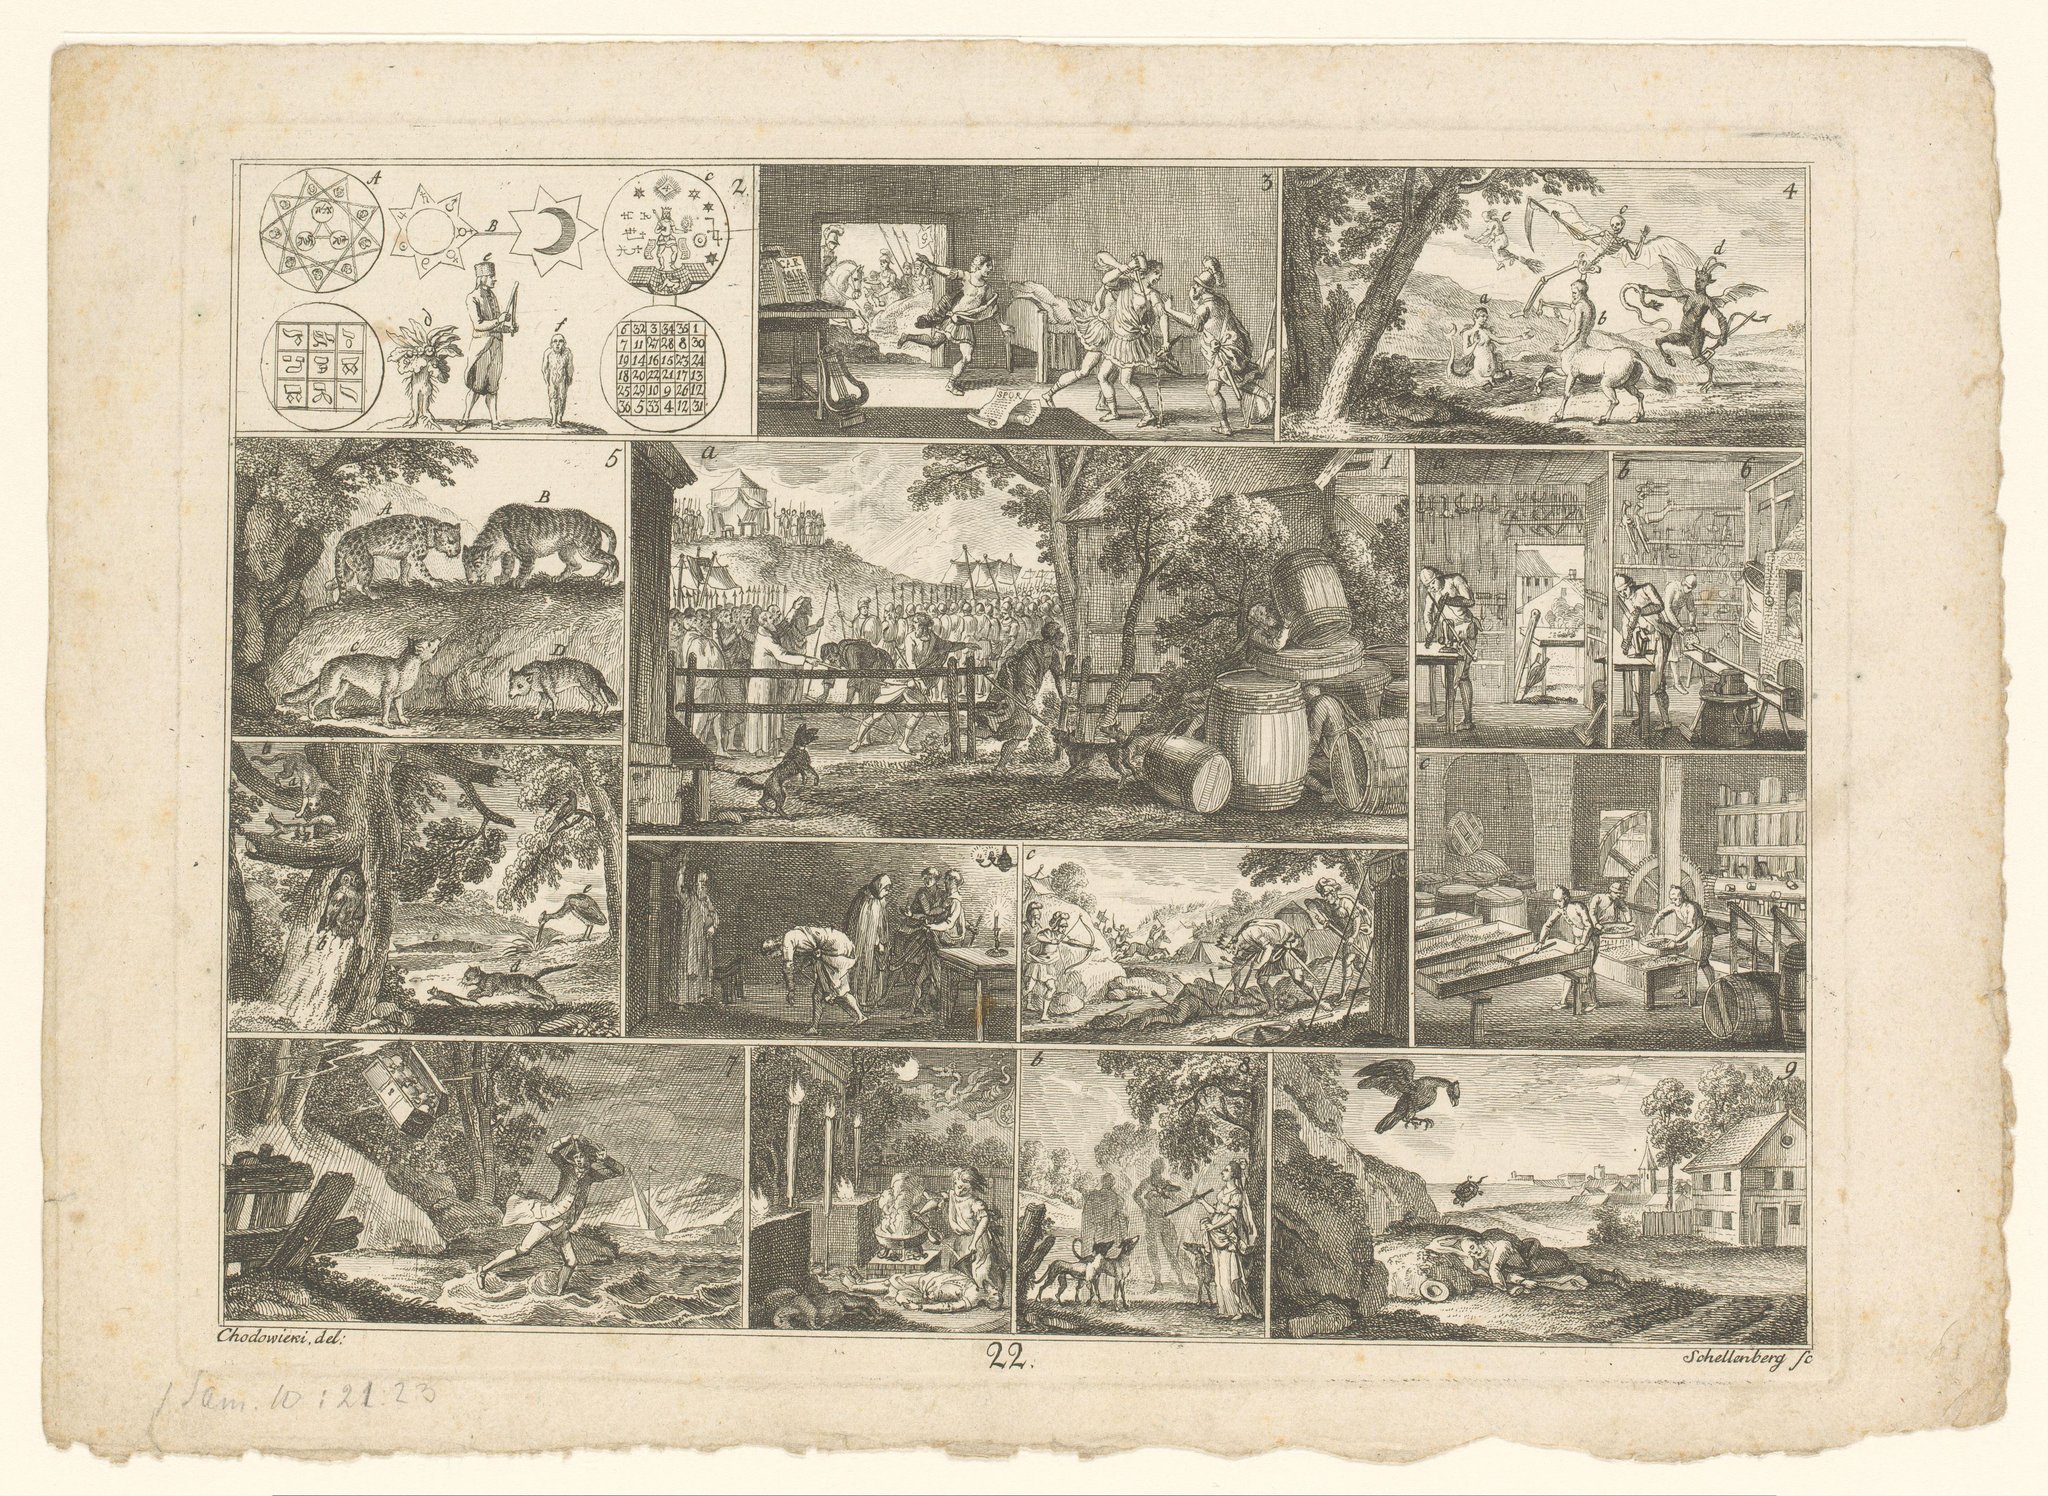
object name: print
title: Encyclopedische voorstellingen voor de jeugd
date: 1784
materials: paper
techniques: engraving, etching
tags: samuel admonishes saul to slay the amalekites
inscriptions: collector's mark: Lugt 2228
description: Maakt deel uit van een serie encyclopedische prenten door verschillende kunstenaars naar ontwerp van Daniel Nikolaus Chodowiecki bij Johann Sigmund Stoy's 'Bilder-Akademie für die Jugend', uitgegeven te Neurenberg in 1784. De prenten waren bedoeld voor kinderen om uit te knippen, op kaarten te plakken en vervolgens op logische wijze te rangschikken (zie Heesen, Anke te. The World in a Box: The Story of an Eighteenth-Century Picture Encyclopedia. Chicago: University of Chicago Press, 2002).